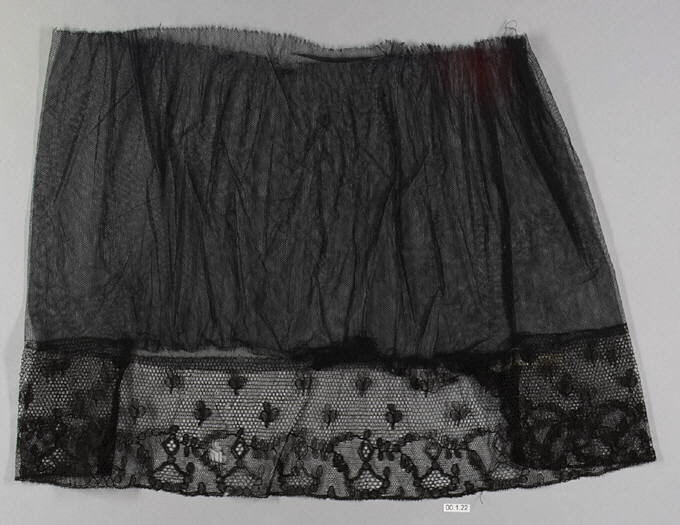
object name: fragment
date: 1801-1900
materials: silk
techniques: lace